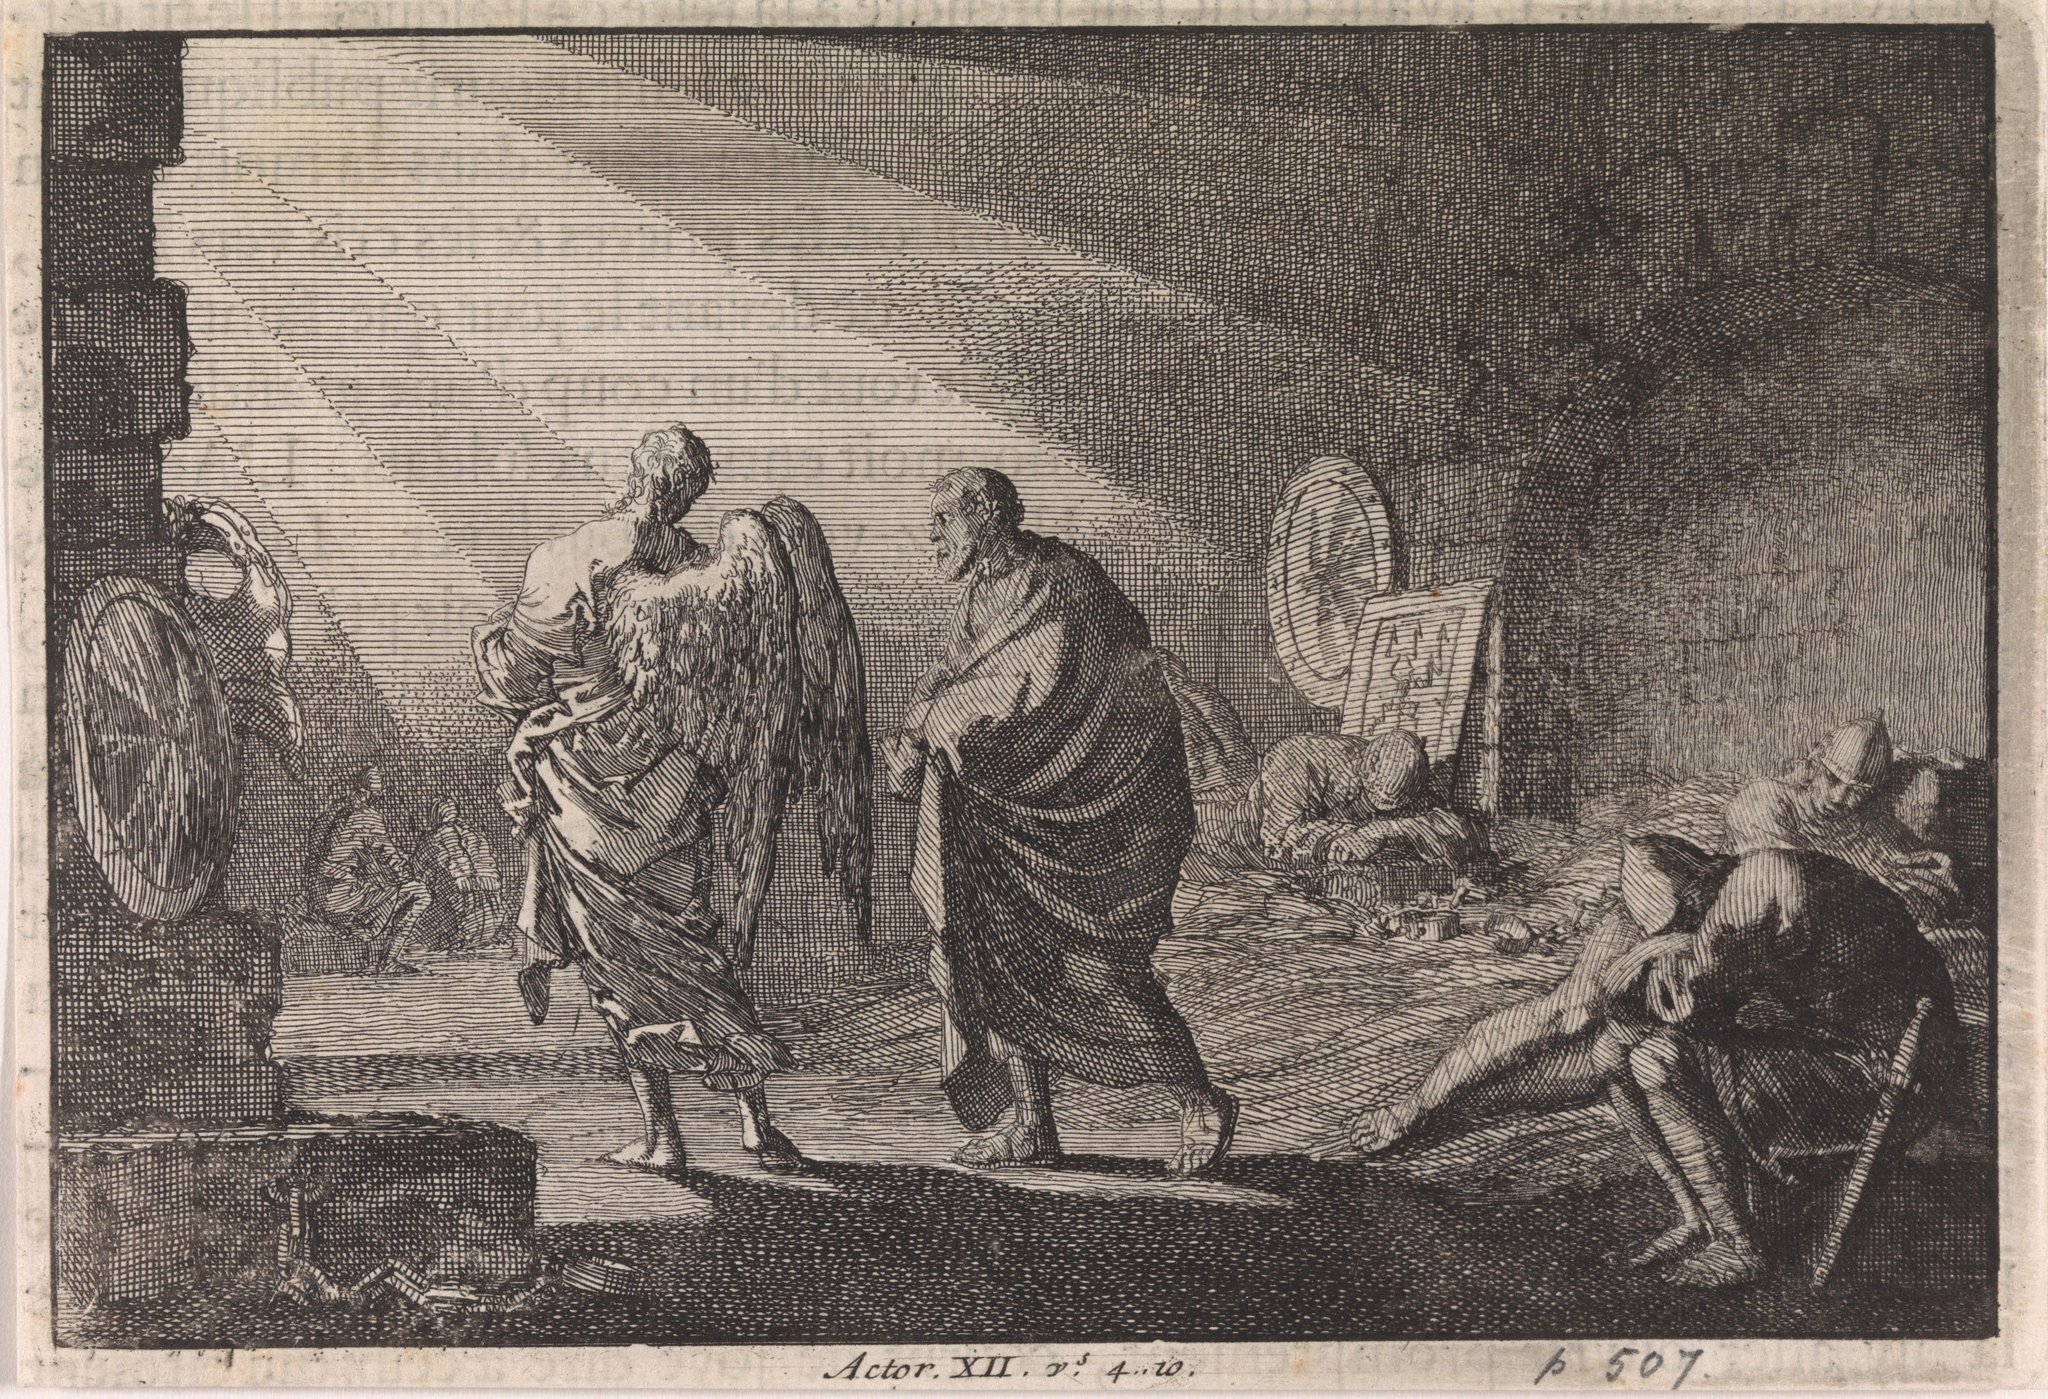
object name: print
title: Petrus door de engel uit de gevangenis bevrijd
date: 1703-1762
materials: paper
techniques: etching, letterpress printing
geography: amsterdam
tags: prison, jail, the angel leads peter past the sleeping guards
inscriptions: collector's mark: Lugt 2228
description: De prent komt een eerste keer voor als boekillustratie voor David Martin. Historie des Ouden en Nieuwen Testaments. Amsterdam, Pieter Mortier, 1703. Deel II. De boekillustraties voor de Mortierbijbel hebben verschillende staten en kopieën, waarbij de chronologische volgorde moeilijk te achterhalen valt. Als boekillustraties werden ze bovendien herhaaldelijk opnieuw gebruikt voor andere boekwerken.